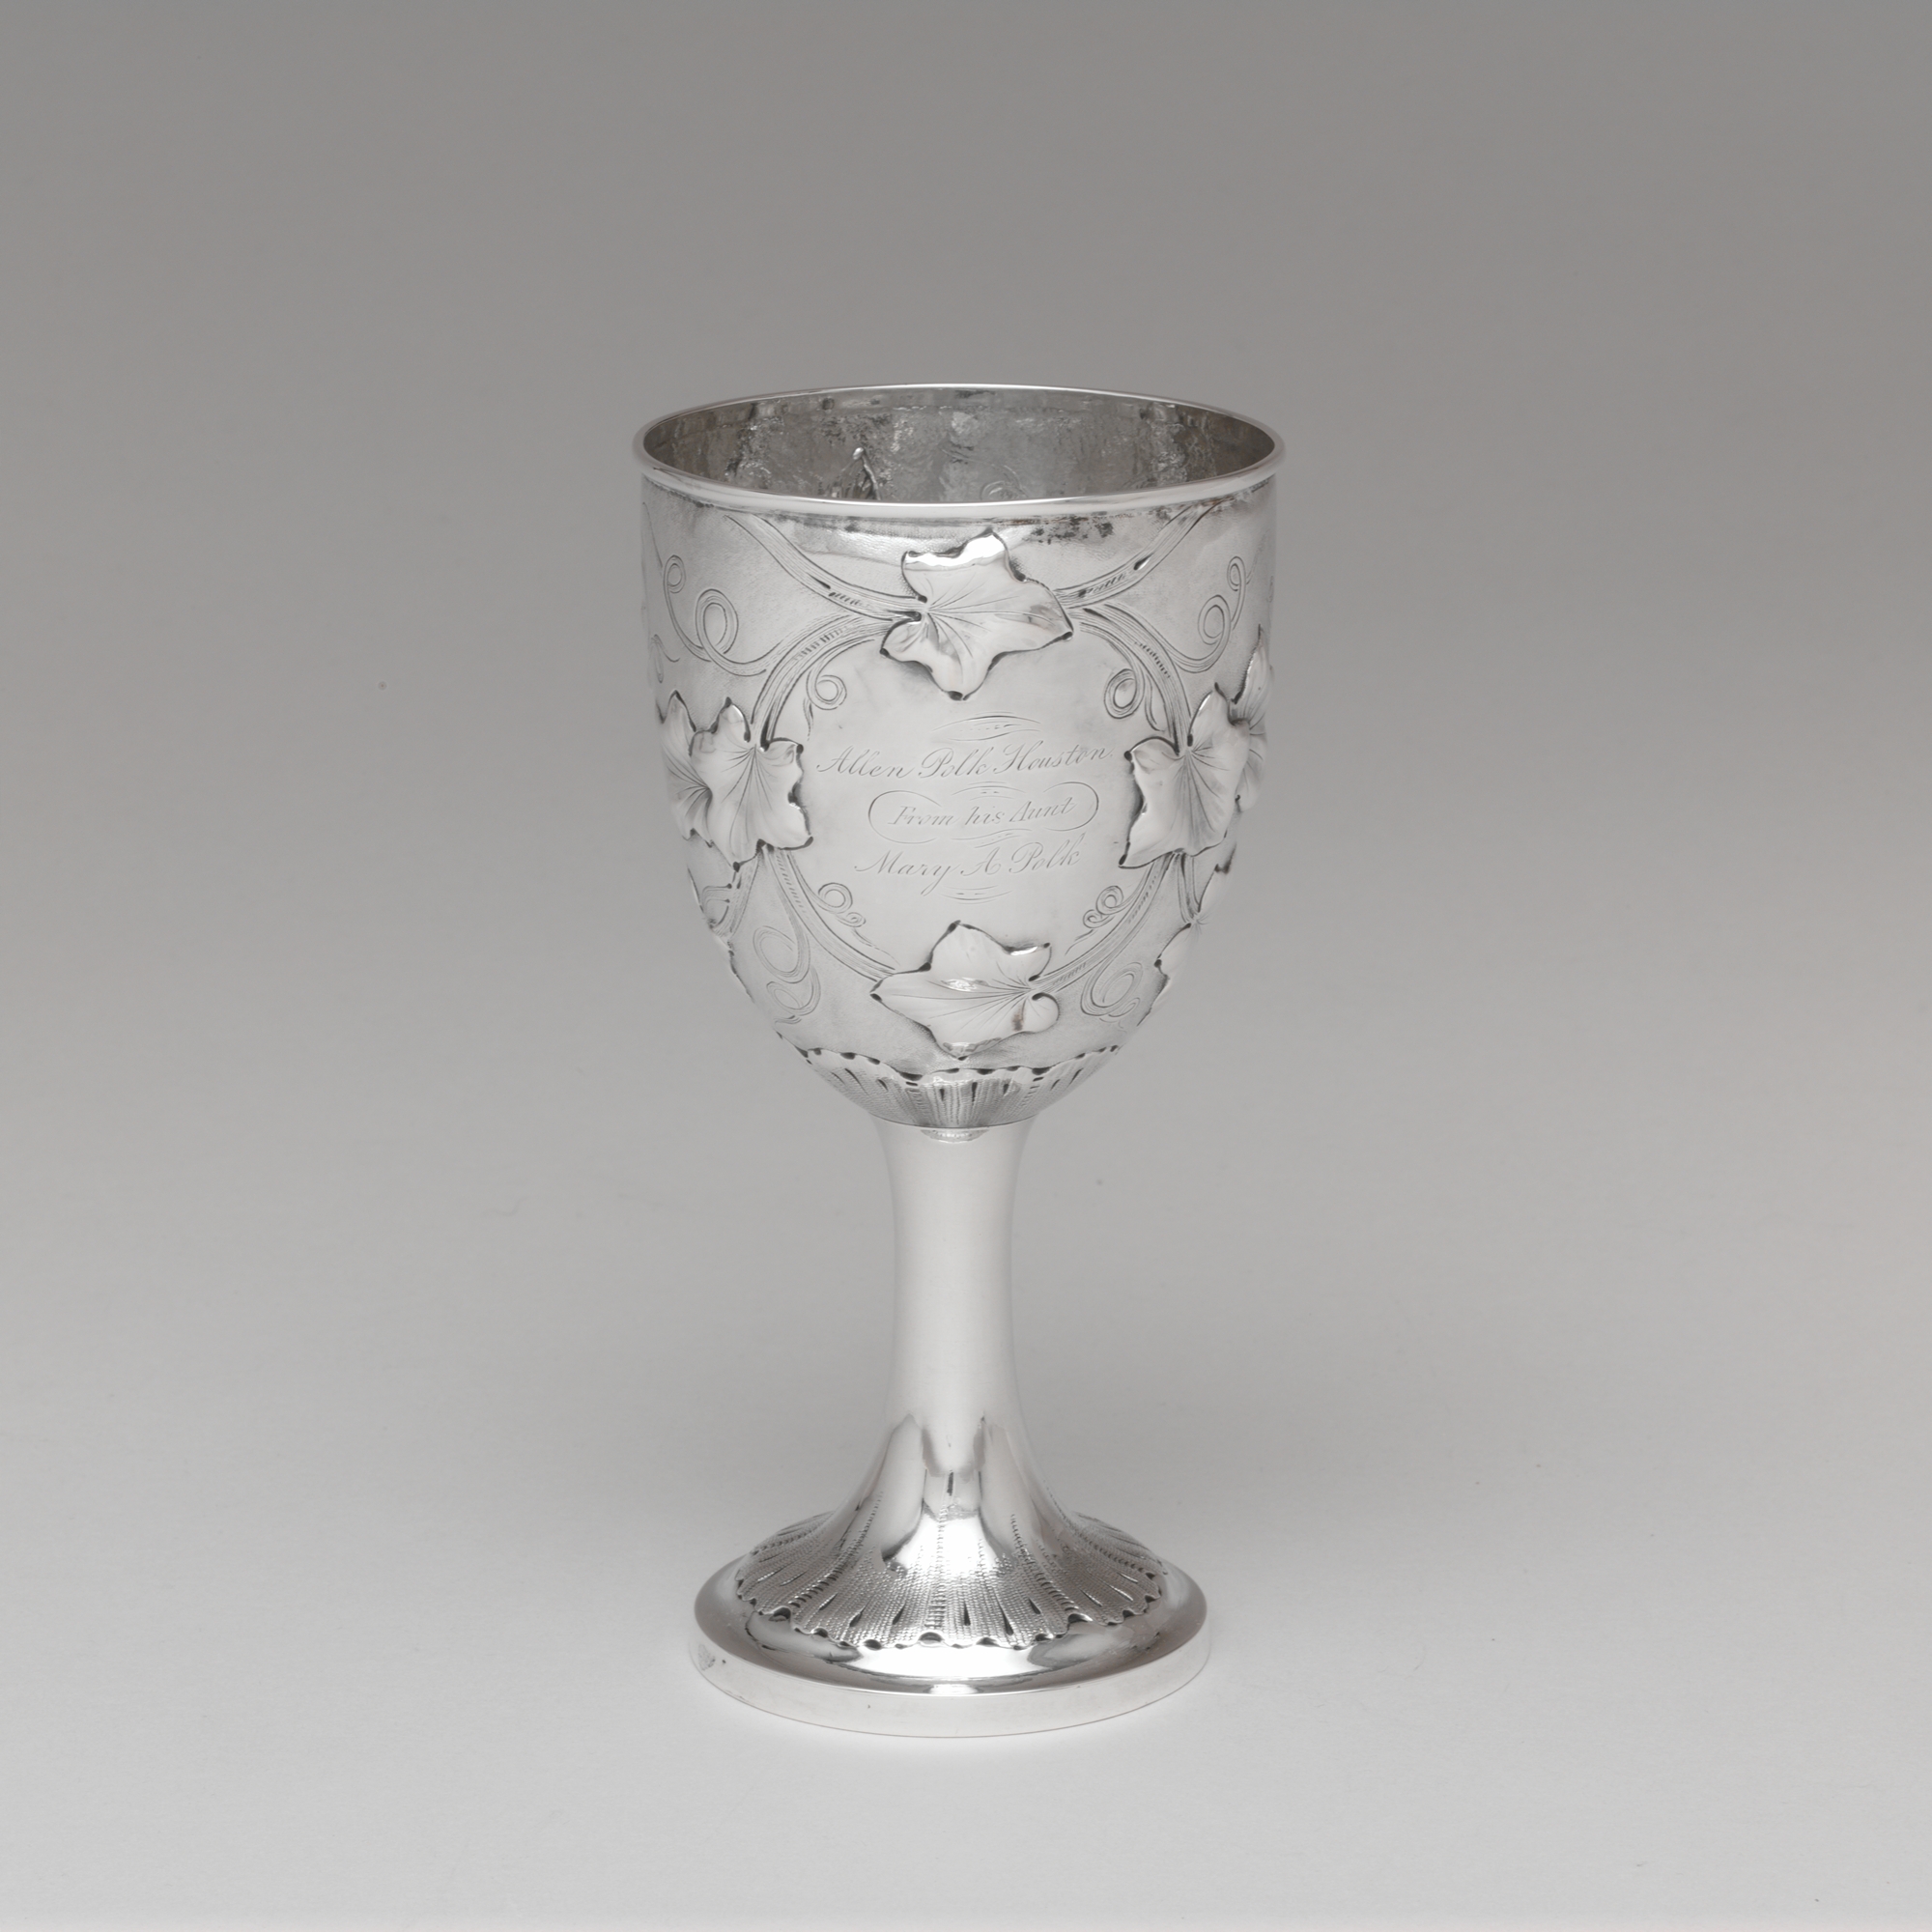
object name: goblet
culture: american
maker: robert and william wilson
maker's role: maker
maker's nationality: american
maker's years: 1825-1846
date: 1845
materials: silver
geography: united states